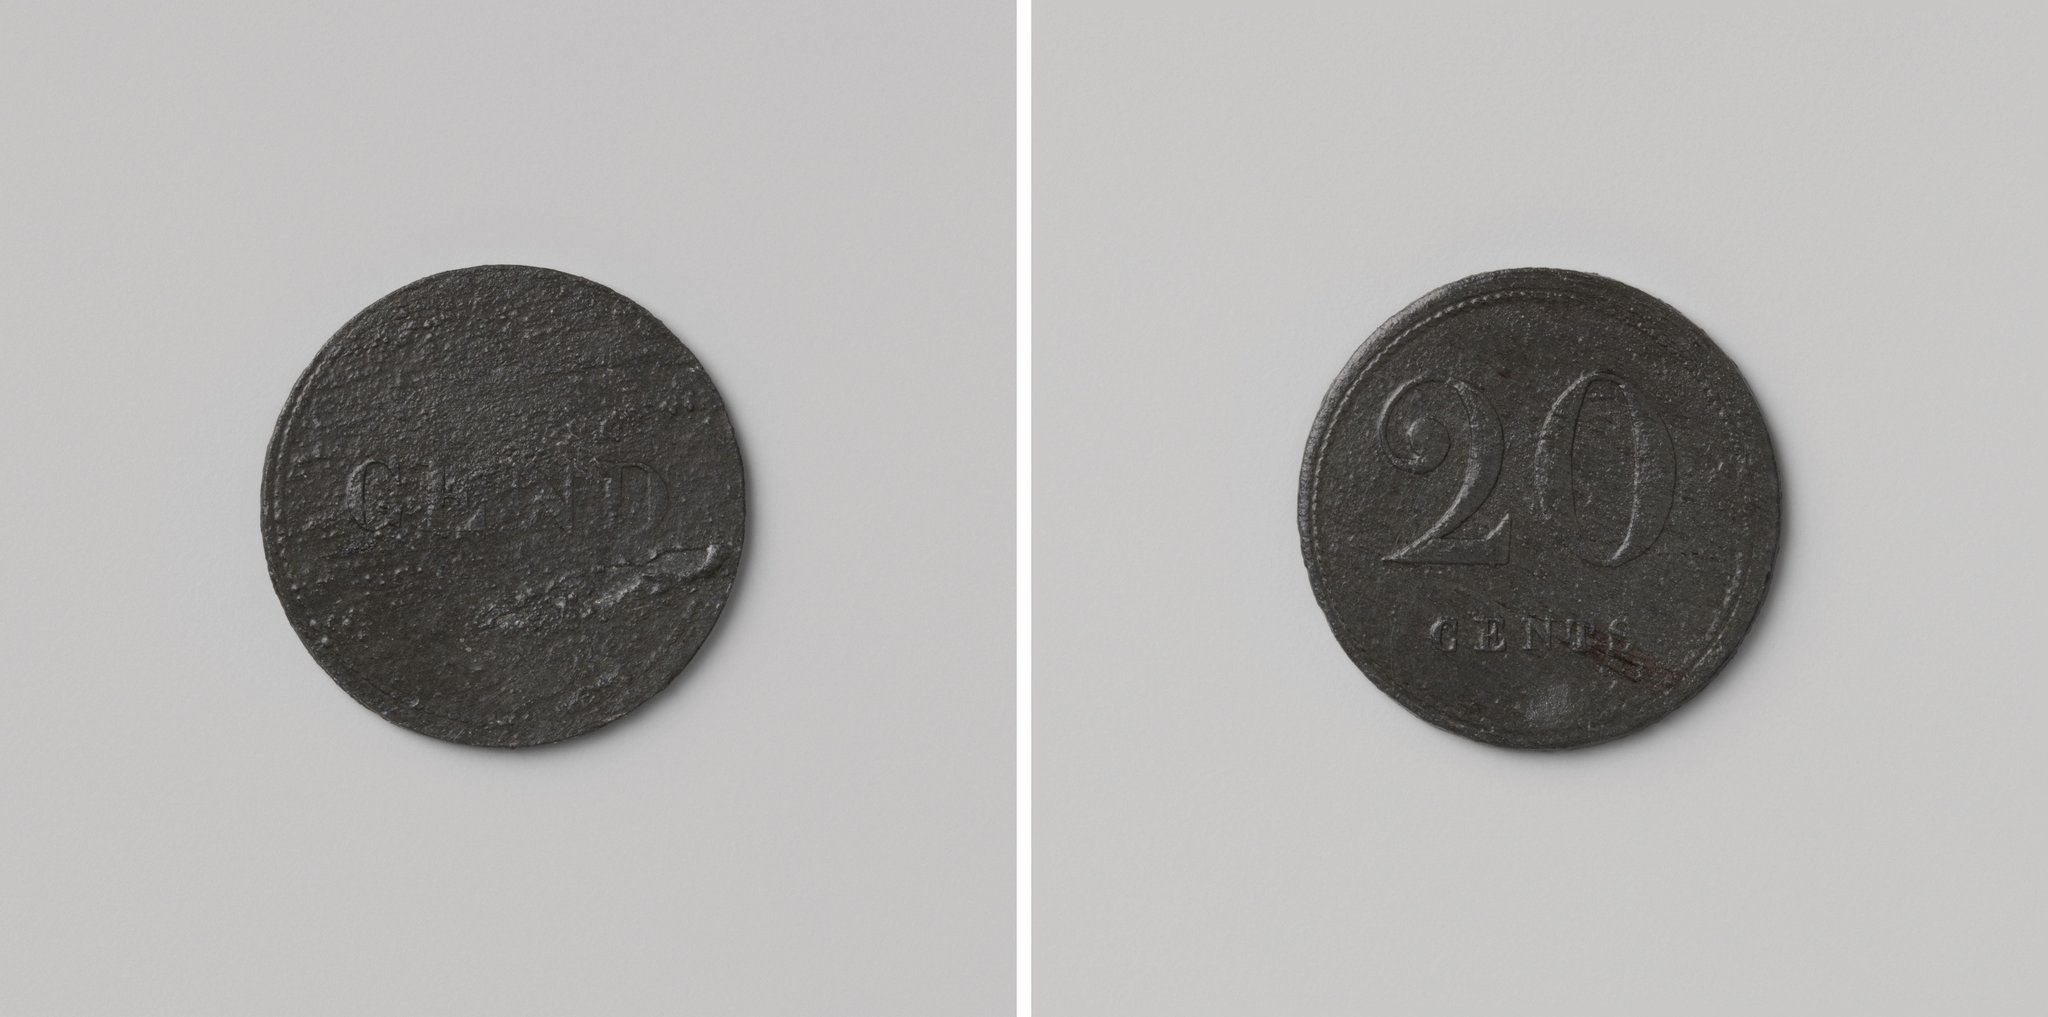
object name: monetary token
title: Strafgevangenis te Gent, huismunt ter waarde van twintig cents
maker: Anonymous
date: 1826-1833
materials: zinc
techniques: striking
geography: brussels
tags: ghent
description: Zinken betaalpenning. Voorzijde: opschrift binnen omschrift. Keerzijde: waardeaanduiding